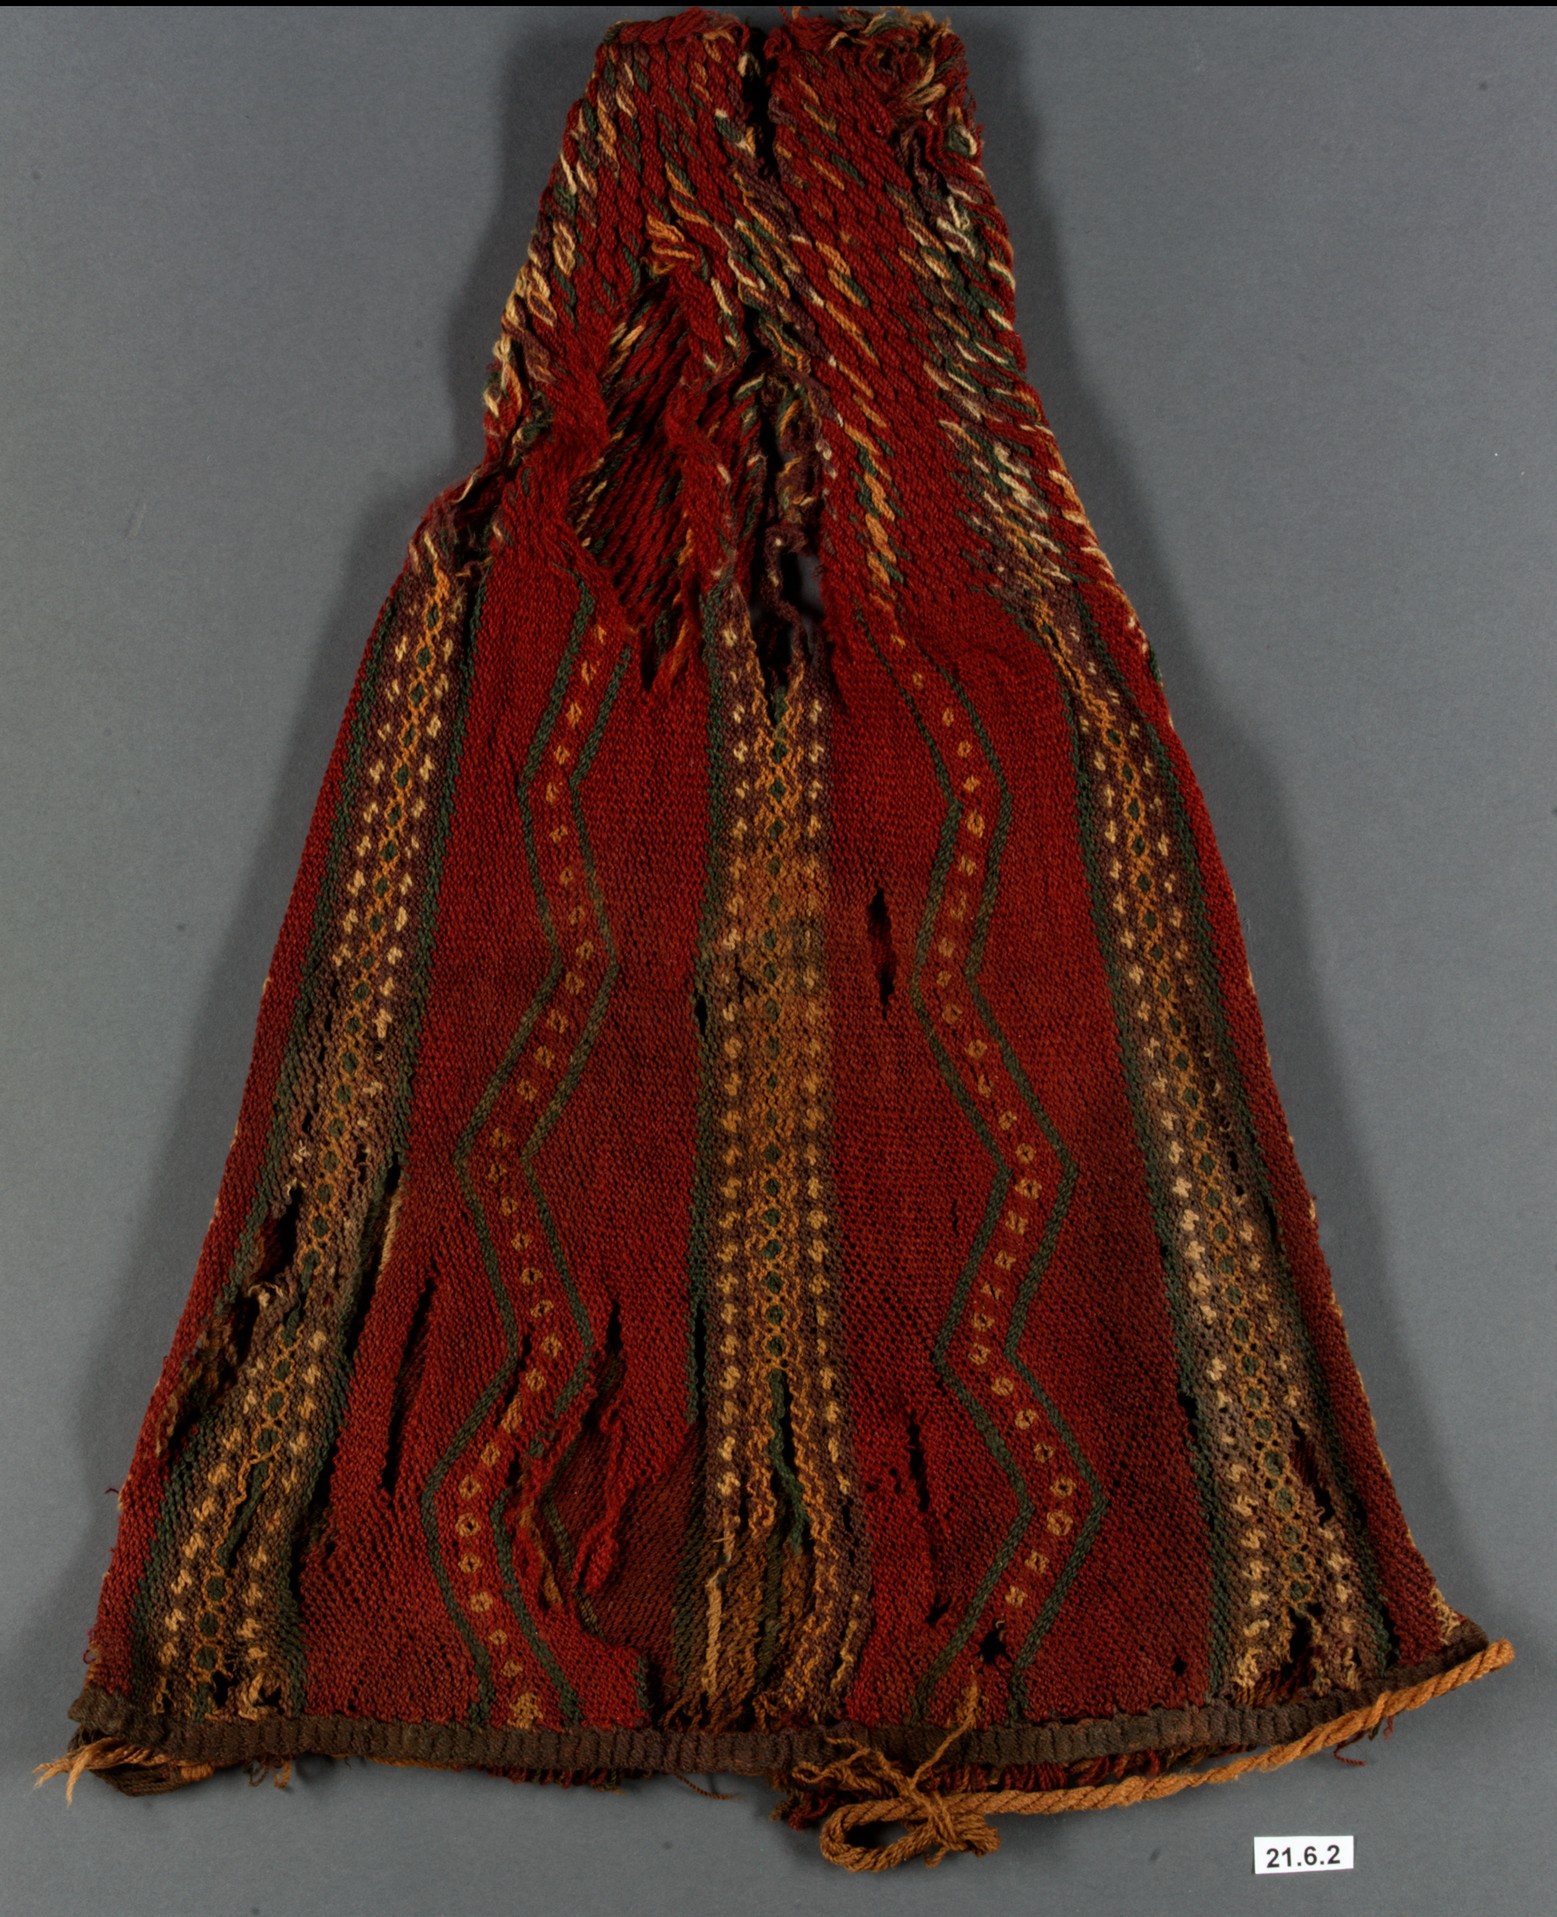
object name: hat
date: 401-800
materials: wool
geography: egypt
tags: hats